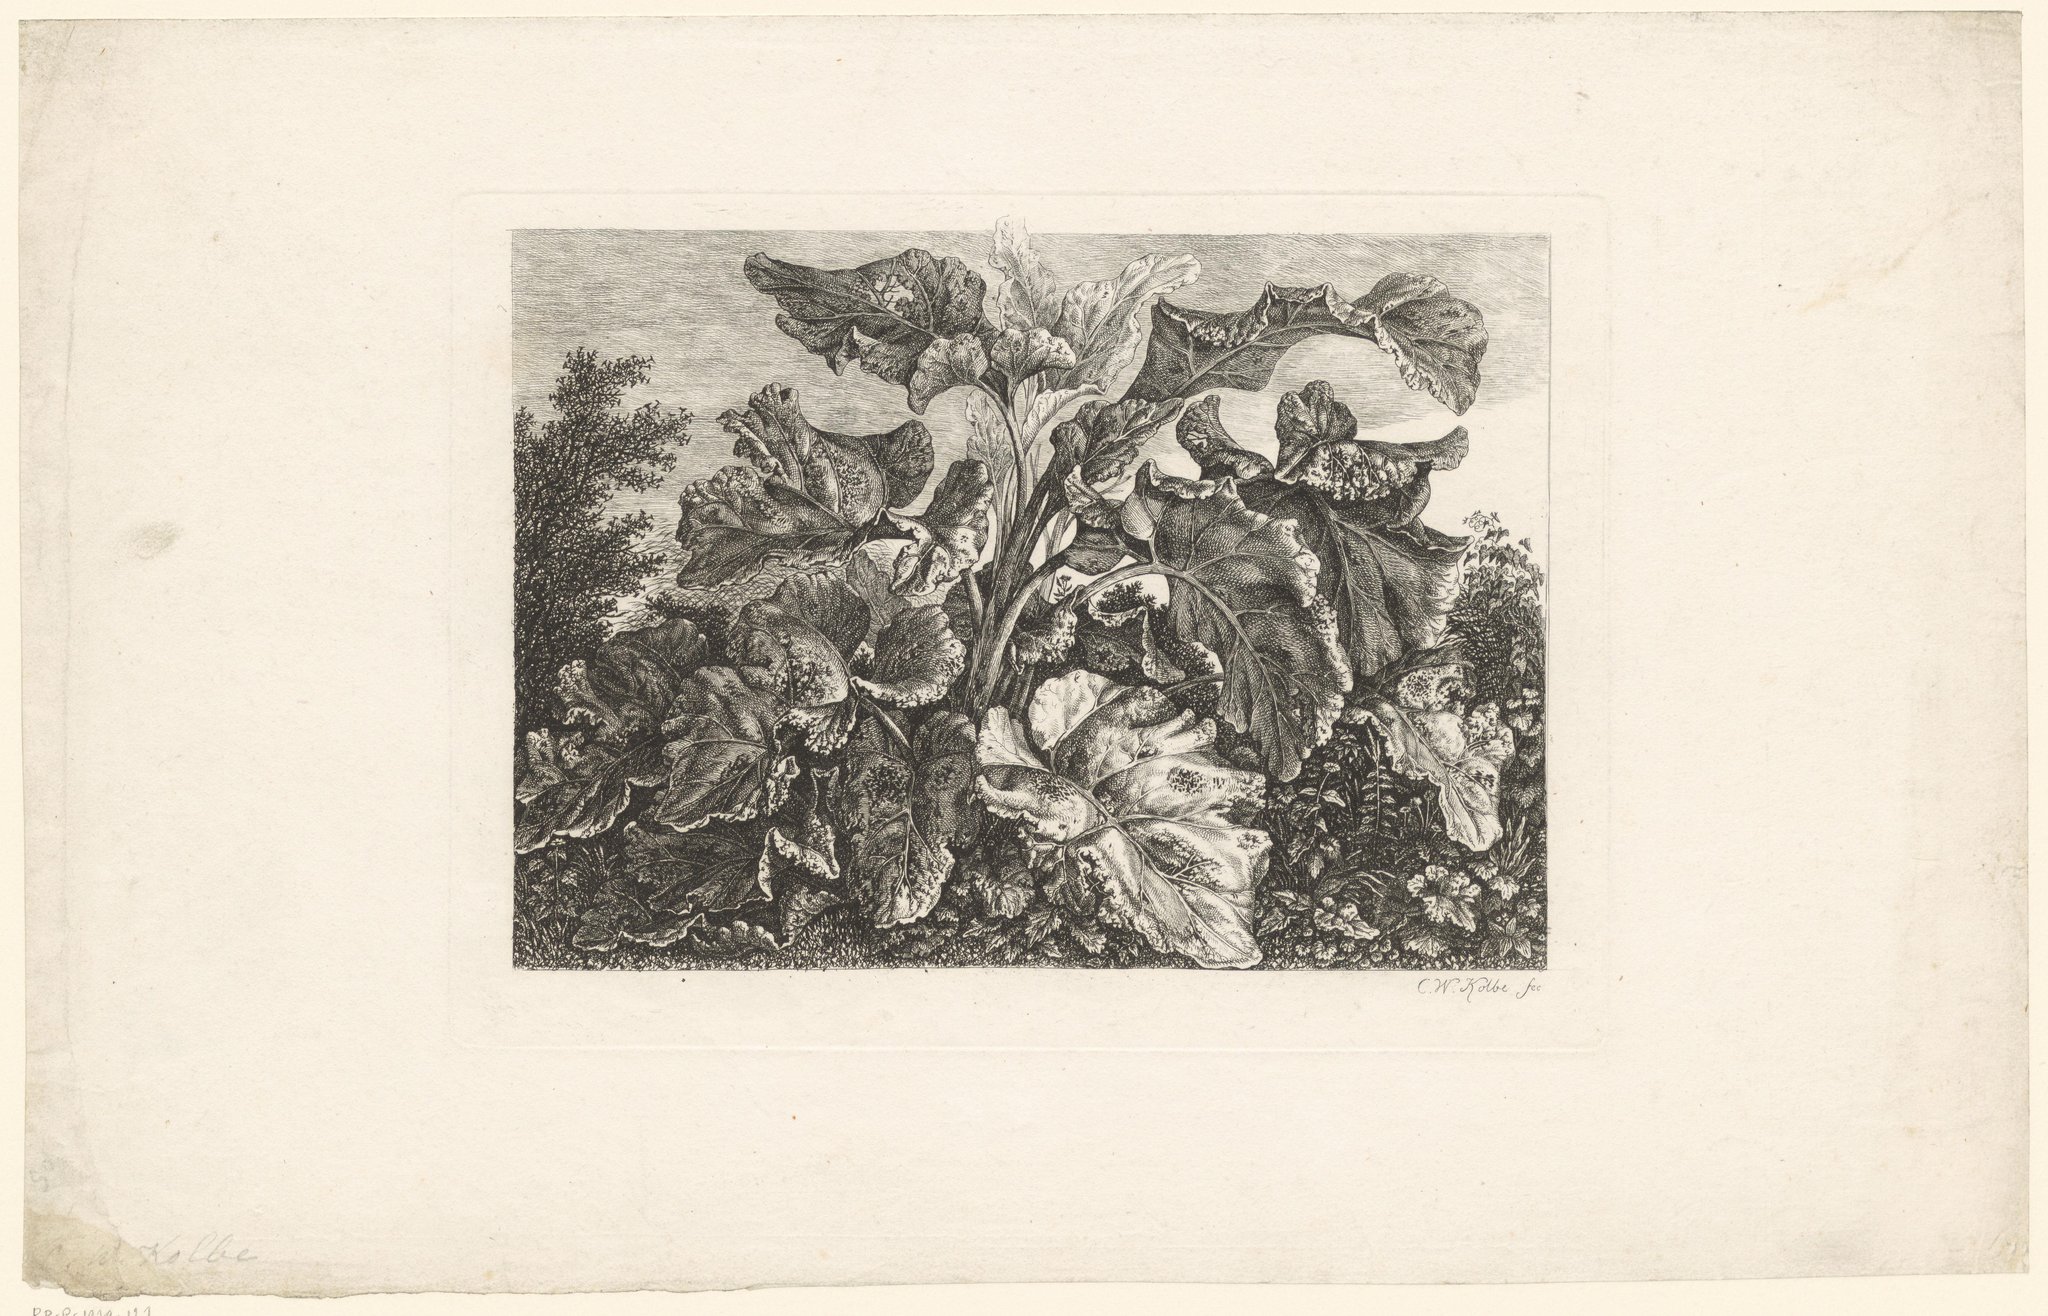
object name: print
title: Bladeren van de grote klit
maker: carl wilhelm kolbe (i)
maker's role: print maker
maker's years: 1757-1835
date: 1767-1835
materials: paper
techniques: etching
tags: lower plants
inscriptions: collector's mark: Lugt 2228, collector's mark: Lugt 2760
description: Mogelijk een studie van de plant bekend onder de Latijnse naam 'Arctium lappa'.